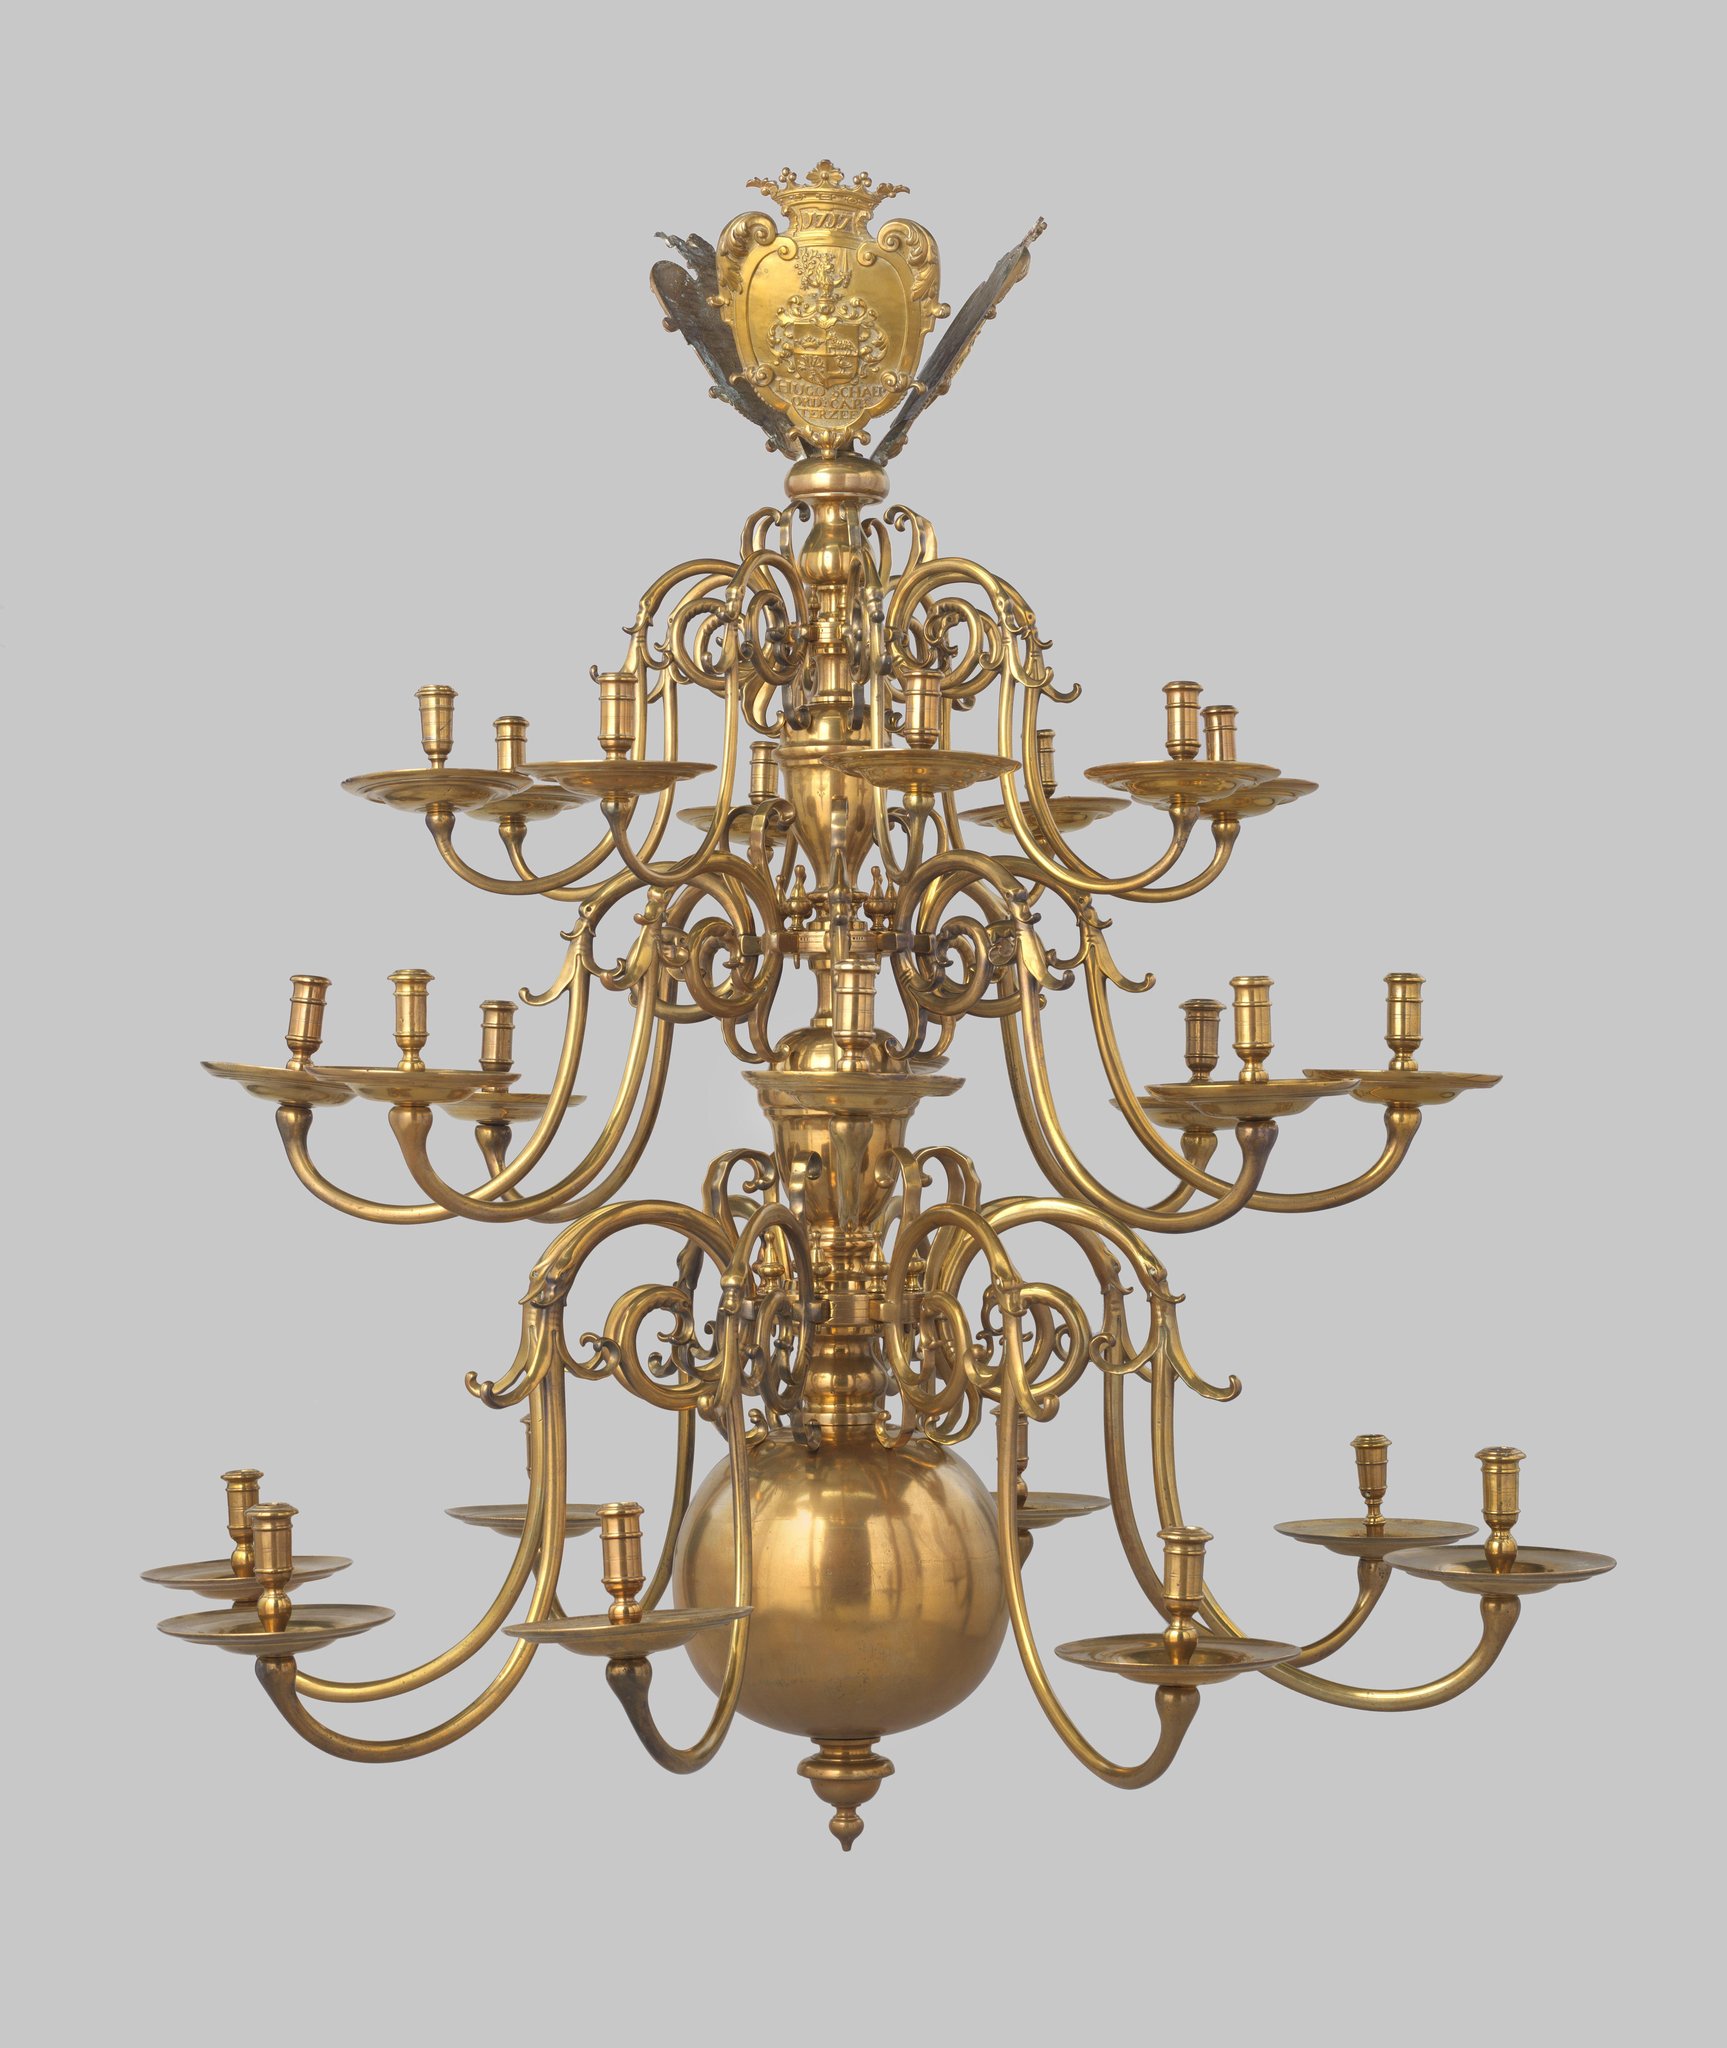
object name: chandelier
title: Arm van een kaarsenkroon in drie hoogten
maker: Anonymous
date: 1717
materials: brass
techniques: casting, screwed, turning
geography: amsterdam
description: De S-vormige arm is aan de stamzijde voorzien van een nok om deze met een pin in de standring te kunnen vastzetten. Bij de stam is de arm op het eind en naar het midden toe versierd met twee gestileerde dolfijnenkoppen en met krullen, waarvan de vorm aan het kwabornament is ontleend. Naar buiten toe eindigt de arm in een verdikking, waarin een van een schroefdraad voorzien gat is aangebracht ter bevestiging van de kaarsenhouder op de vetvanger. De arm is met behulp van hetzelfde model gegoten als de overige armen van de krans. De kaarsenhouder is cylindervormig met geprofileerd uitstekende rand en met een balustervoet, welke overgaat in een van een schroefdraad voorzien eind, waarin onderaan het centergat. De vetvanger is aan de bovenkant naar het midden toe één keer verdiept. Aan de onderkant is deze rond het gat in het enigszins bolvormige midden geprofileerd en is de rand geribd. De vetvanger met behulp van hetzelfde model gegoten als de overige vetvangers van deze krans. De pin is voorzien van een vaasvormige knop. Dit is de zesde arm van de onderste standring, genummerd op de nok met het cijfer VI.